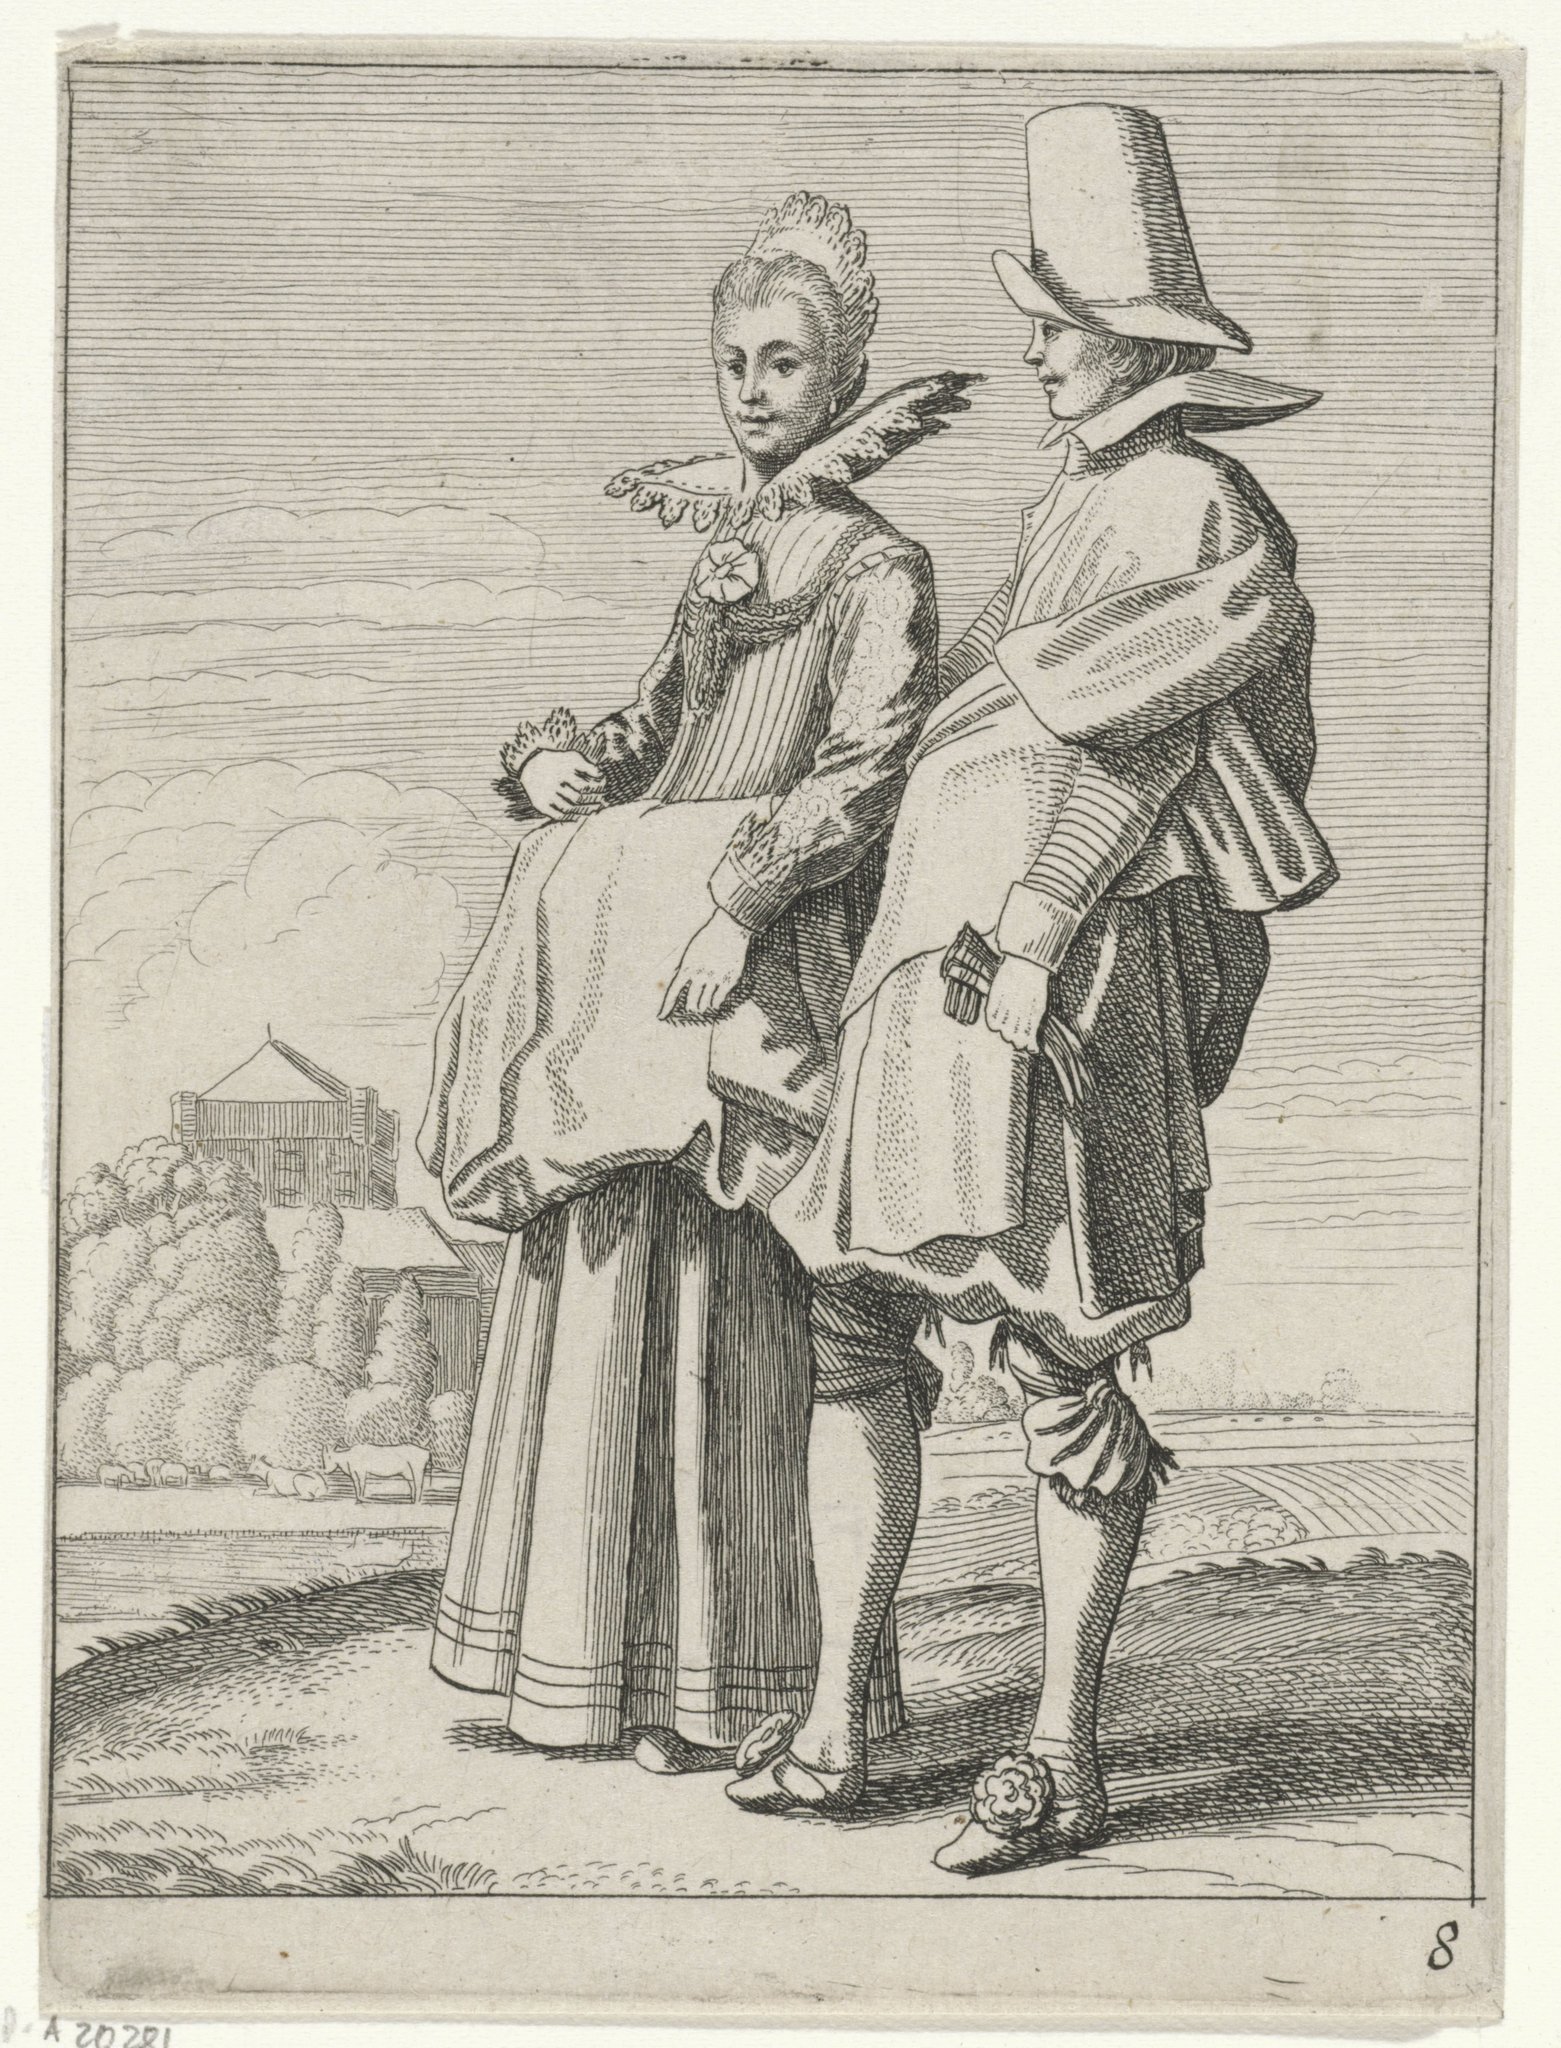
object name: costume print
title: Elegant gekleed paar H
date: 1603-1652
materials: paper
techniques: engraving, etching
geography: amsterdam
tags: cape (+ men's clothes), head-gear (boogmuts) (+ women's clothes), head-gear: hat (+ men's clothes), clothes, costume (+ women's clothes), skirt (+ women's clothes), sleeves: cuffs (+ women's clothes), dress, gown (+ women's clothes), shoes, sandals (+ men's clothes), clothes, costume (+ men's clothes), neck-gear: collar (+ men's clothes), trousers, breeches, etc. (breeches) (+ men's clothes), clothing for the upper part of the body (doublet) (+ men's clothes), gloves, mittens, etc. (+ men's clothes), sleeves (+ women's clothes), clothing for the upper part of the body (with name) (+ women's clothes), netherlands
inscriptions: number: ‘8’, collector's mark: Lugt 964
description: Man: hoed met hoge cilindervormige bol en kleine, van voren opgeslagen rand. Gladde waaiervormige kraag. Mantel met siermouw. Tot de knie reikende wijde pofbroek. Kniebanden met grote strik. Lage schoenen met hak en striksluiting. Handschoen in de linkerhand. Vrouw: Diadeemmuts. Waaiervormige opstaande kraag met kant. Lijfje met rozet en manchetten met kant. Kleine schouderklep. Opgeslagen rok.